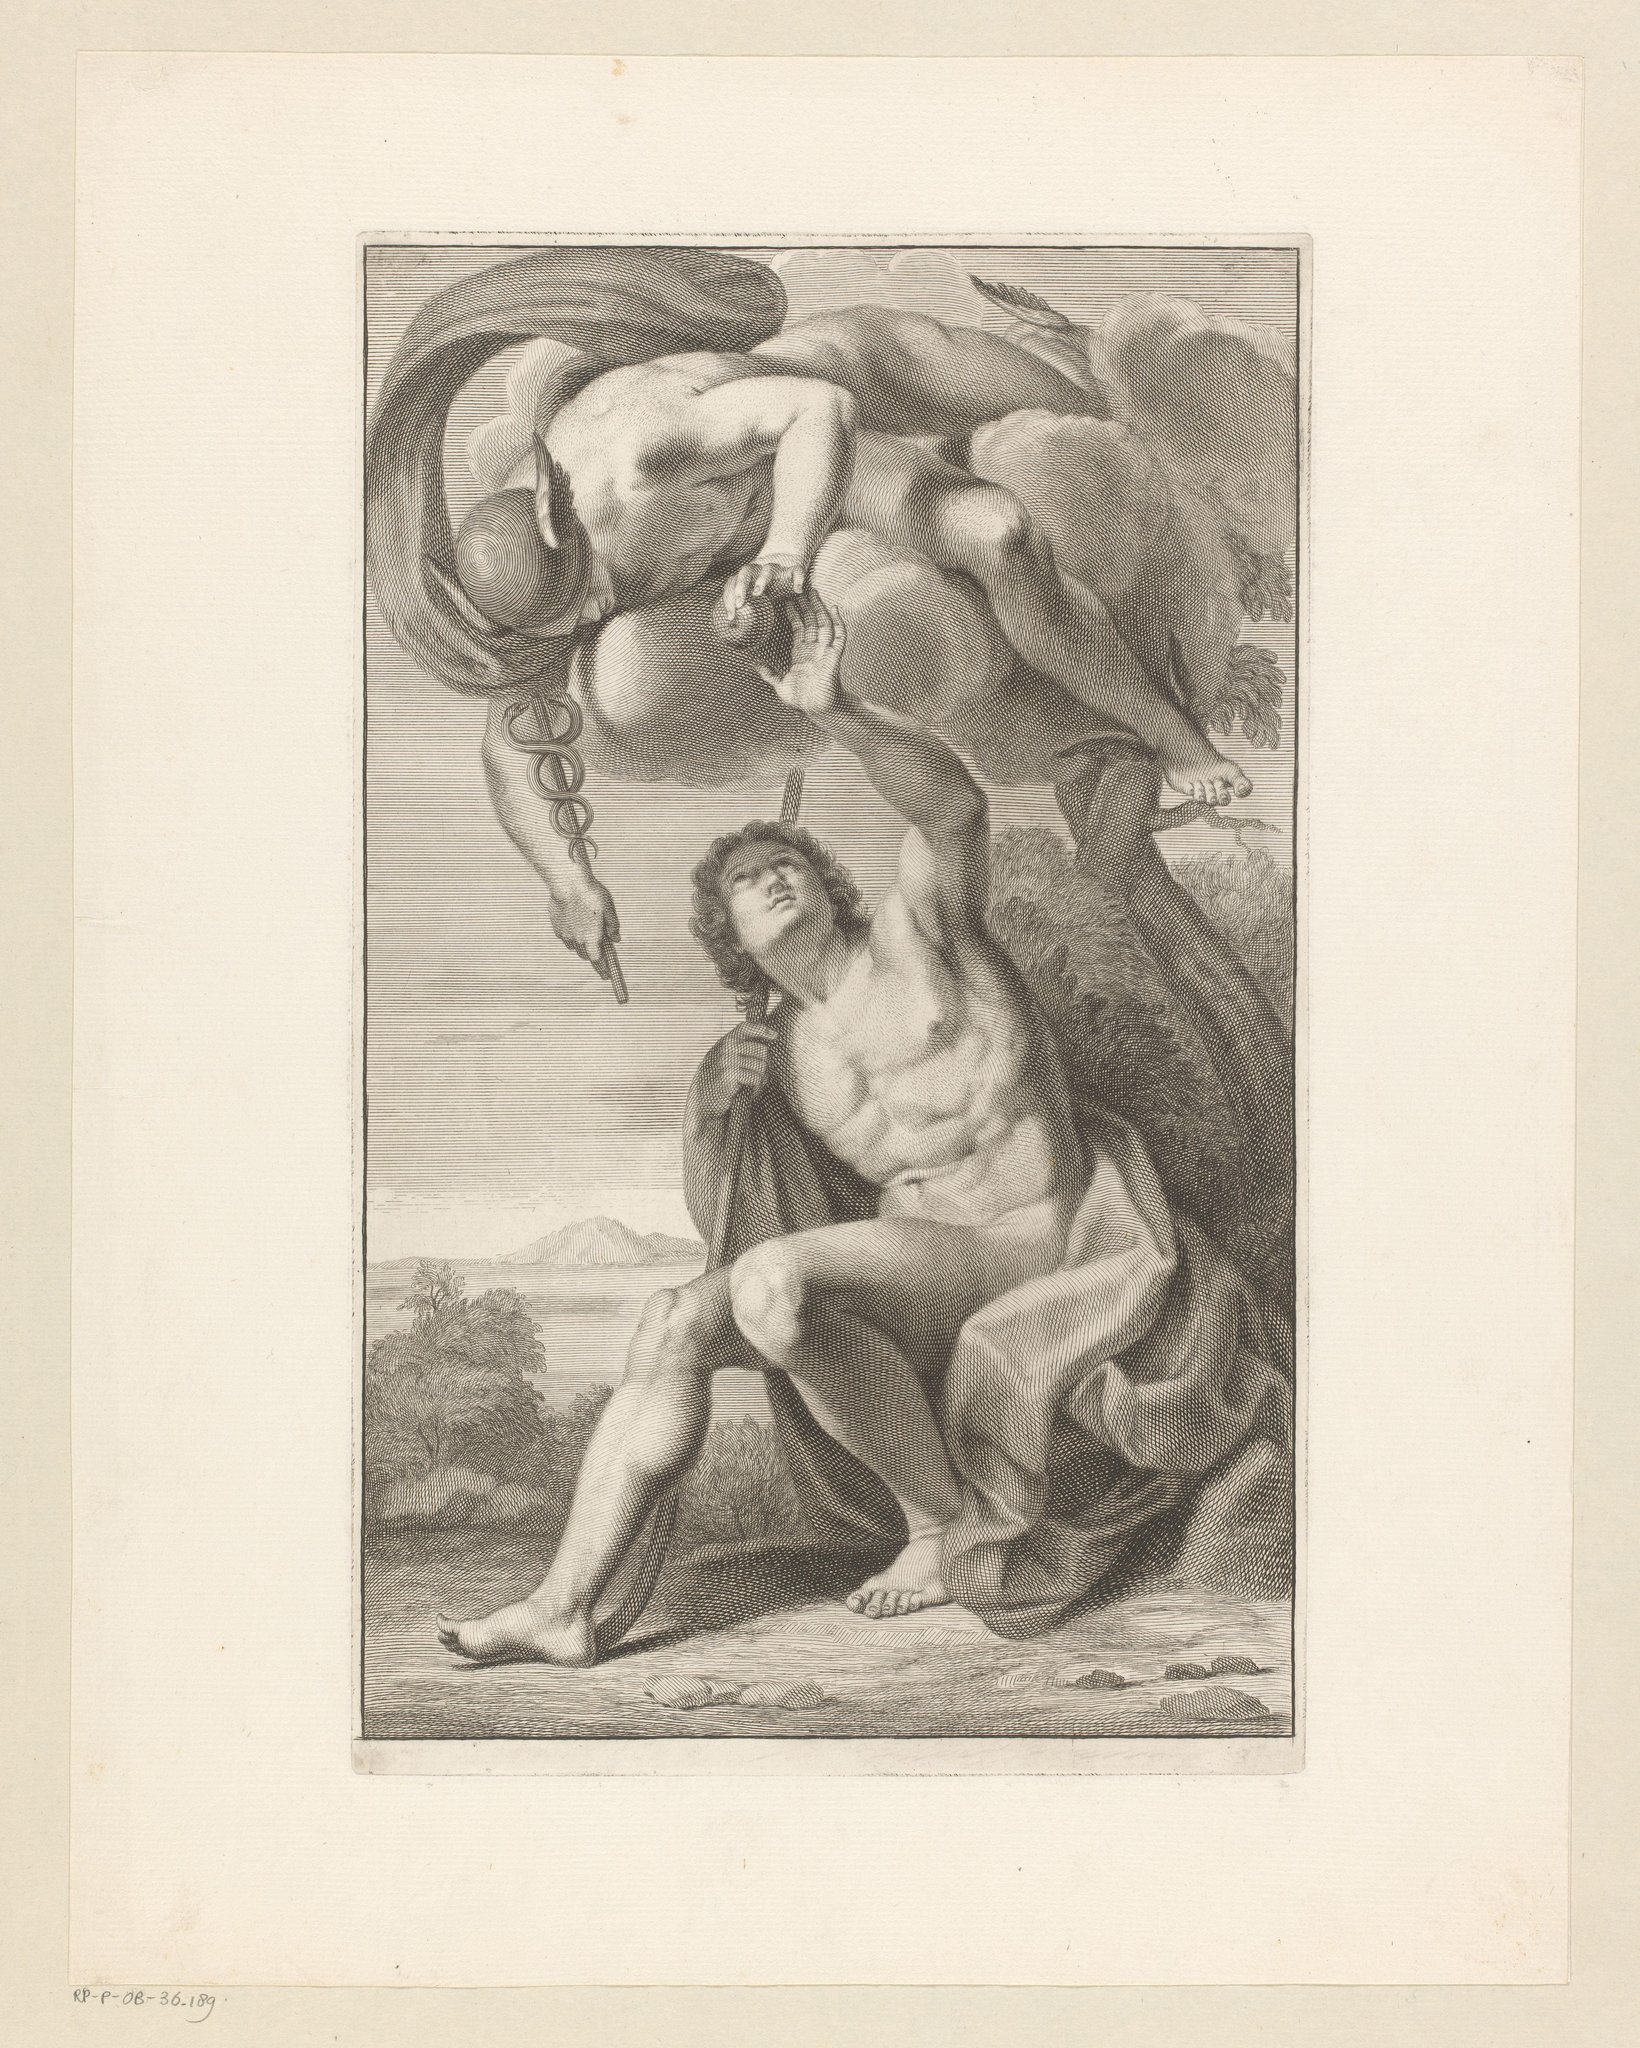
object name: print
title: Mercurius geeft Paris de gouden appel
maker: giovanni girolamo frezza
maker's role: print maker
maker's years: 1659-1748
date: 1686-1748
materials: paper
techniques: engraving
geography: rome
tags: (story of) mercury (hermes), mercury brings paris the golden apple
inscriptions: collector's mark: Lugt 240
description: Mercurius en Paris in een landschap. Mercurius zweeft in de lucht en geeft Paris de gouden appel.